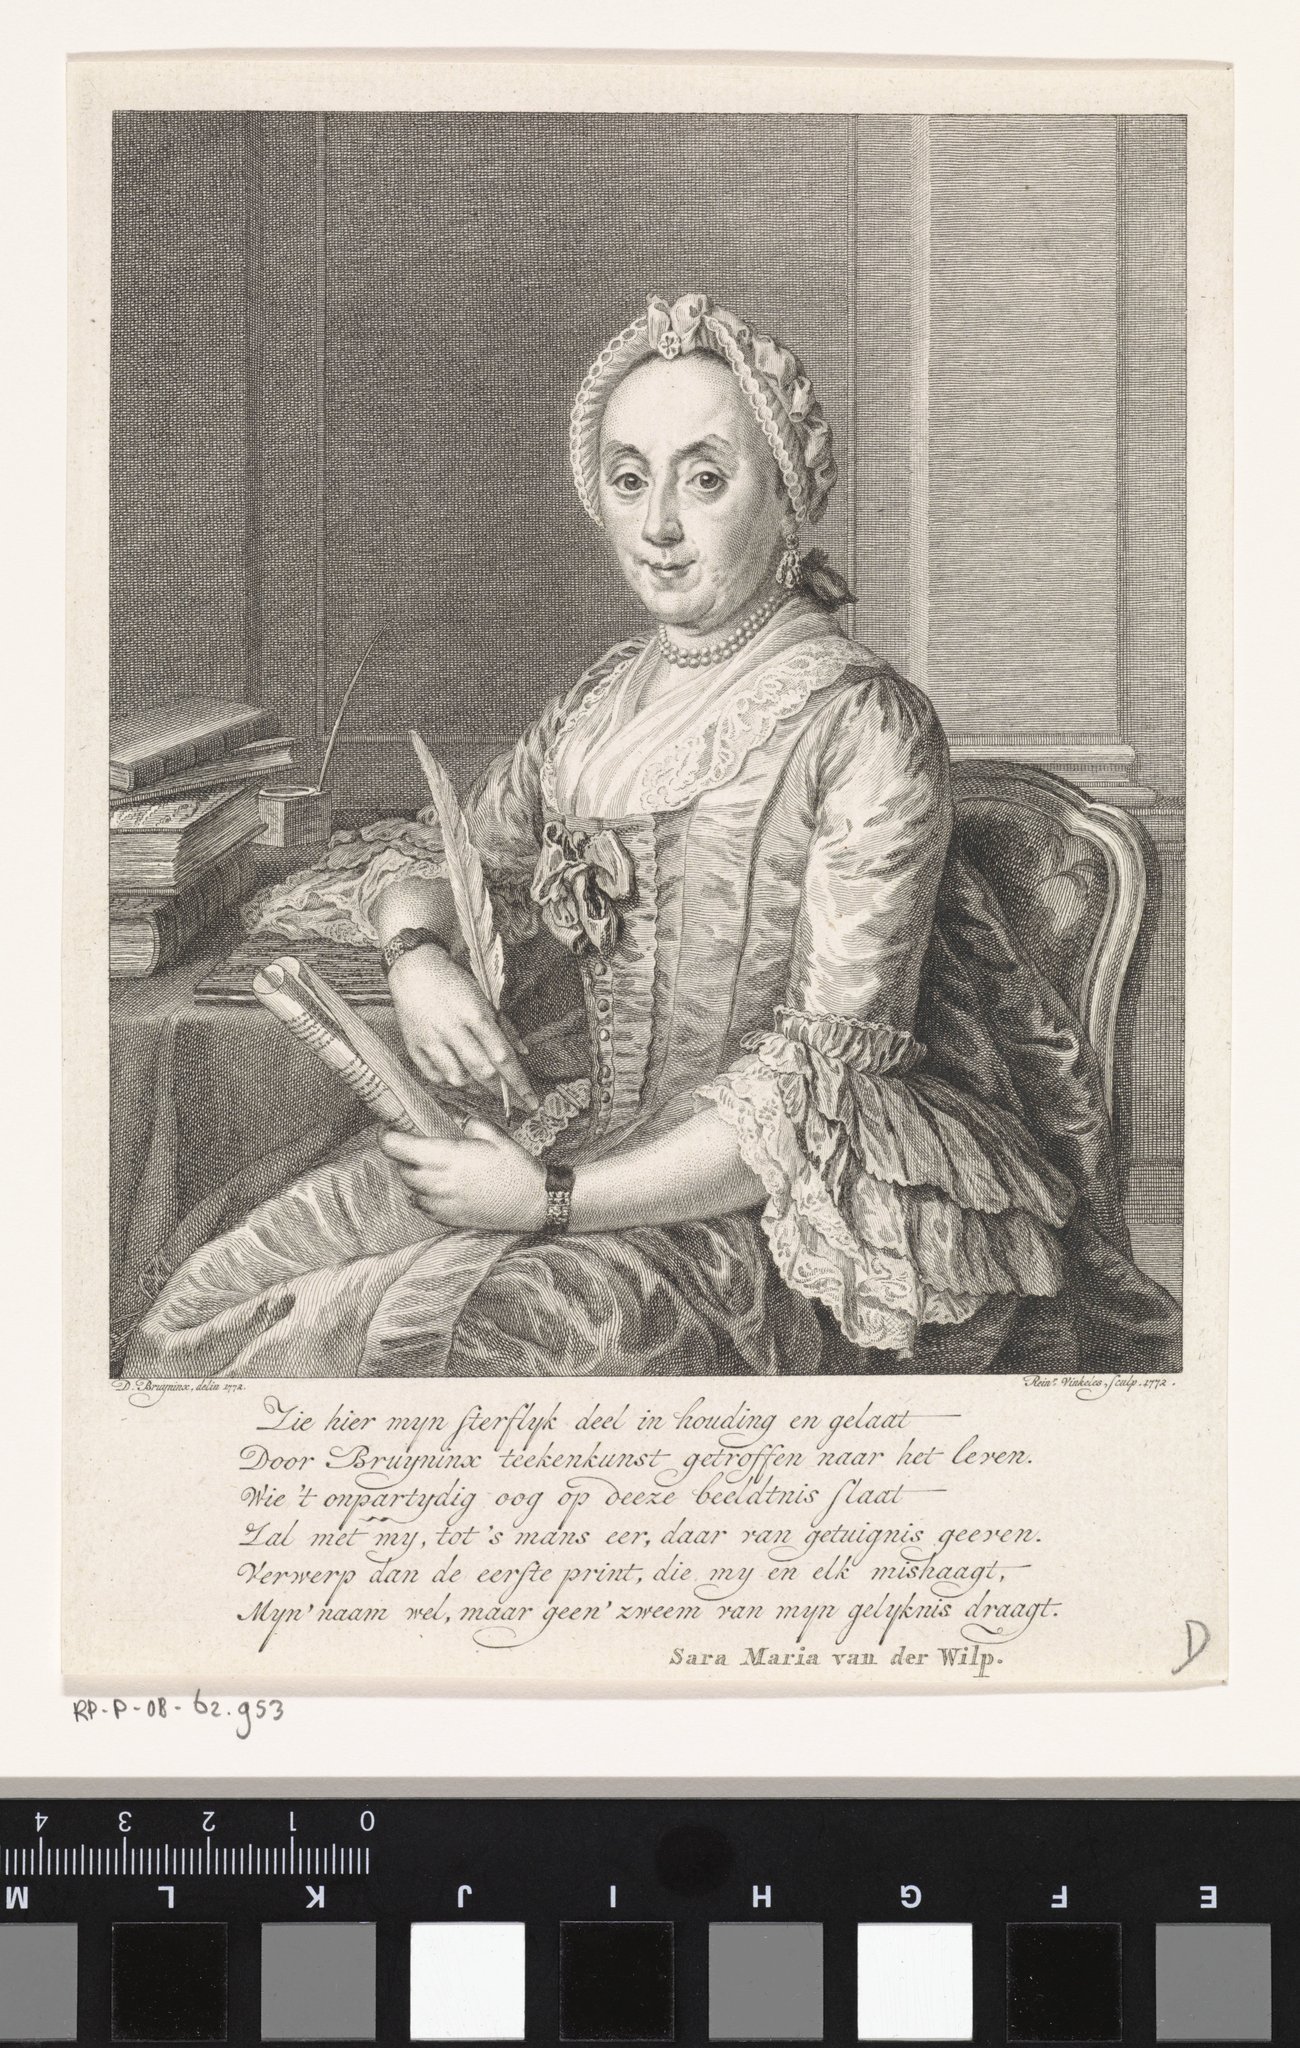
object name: print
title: Portret van Sara Maria van der Wilp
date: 1772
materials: paper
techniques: engraving, etching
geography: amsterdam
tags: sara maria van der wilp, quill, ink-well, paper (writing material)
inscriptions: collector's mark: Lugt 240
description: Portret van de dichteres Sara Maria van der Wilp. Zij zit op een stoel en haar arm leunt op een tafel. In haar handen heeft zij een rol beschreven papier en een schrijfveer. Op tafel staat een inktpot naast een stapel boeken.